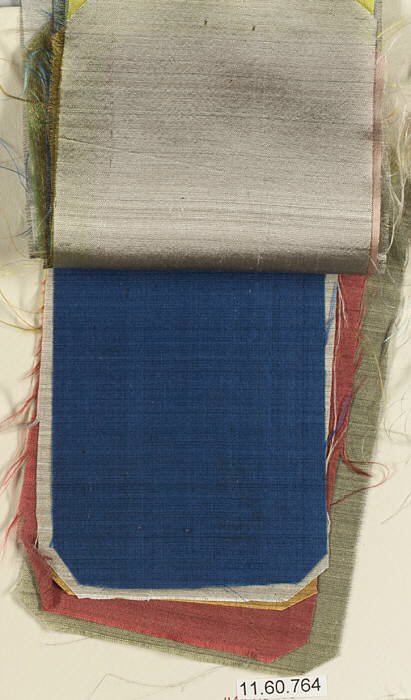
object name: sample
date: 1801-1833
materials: silk